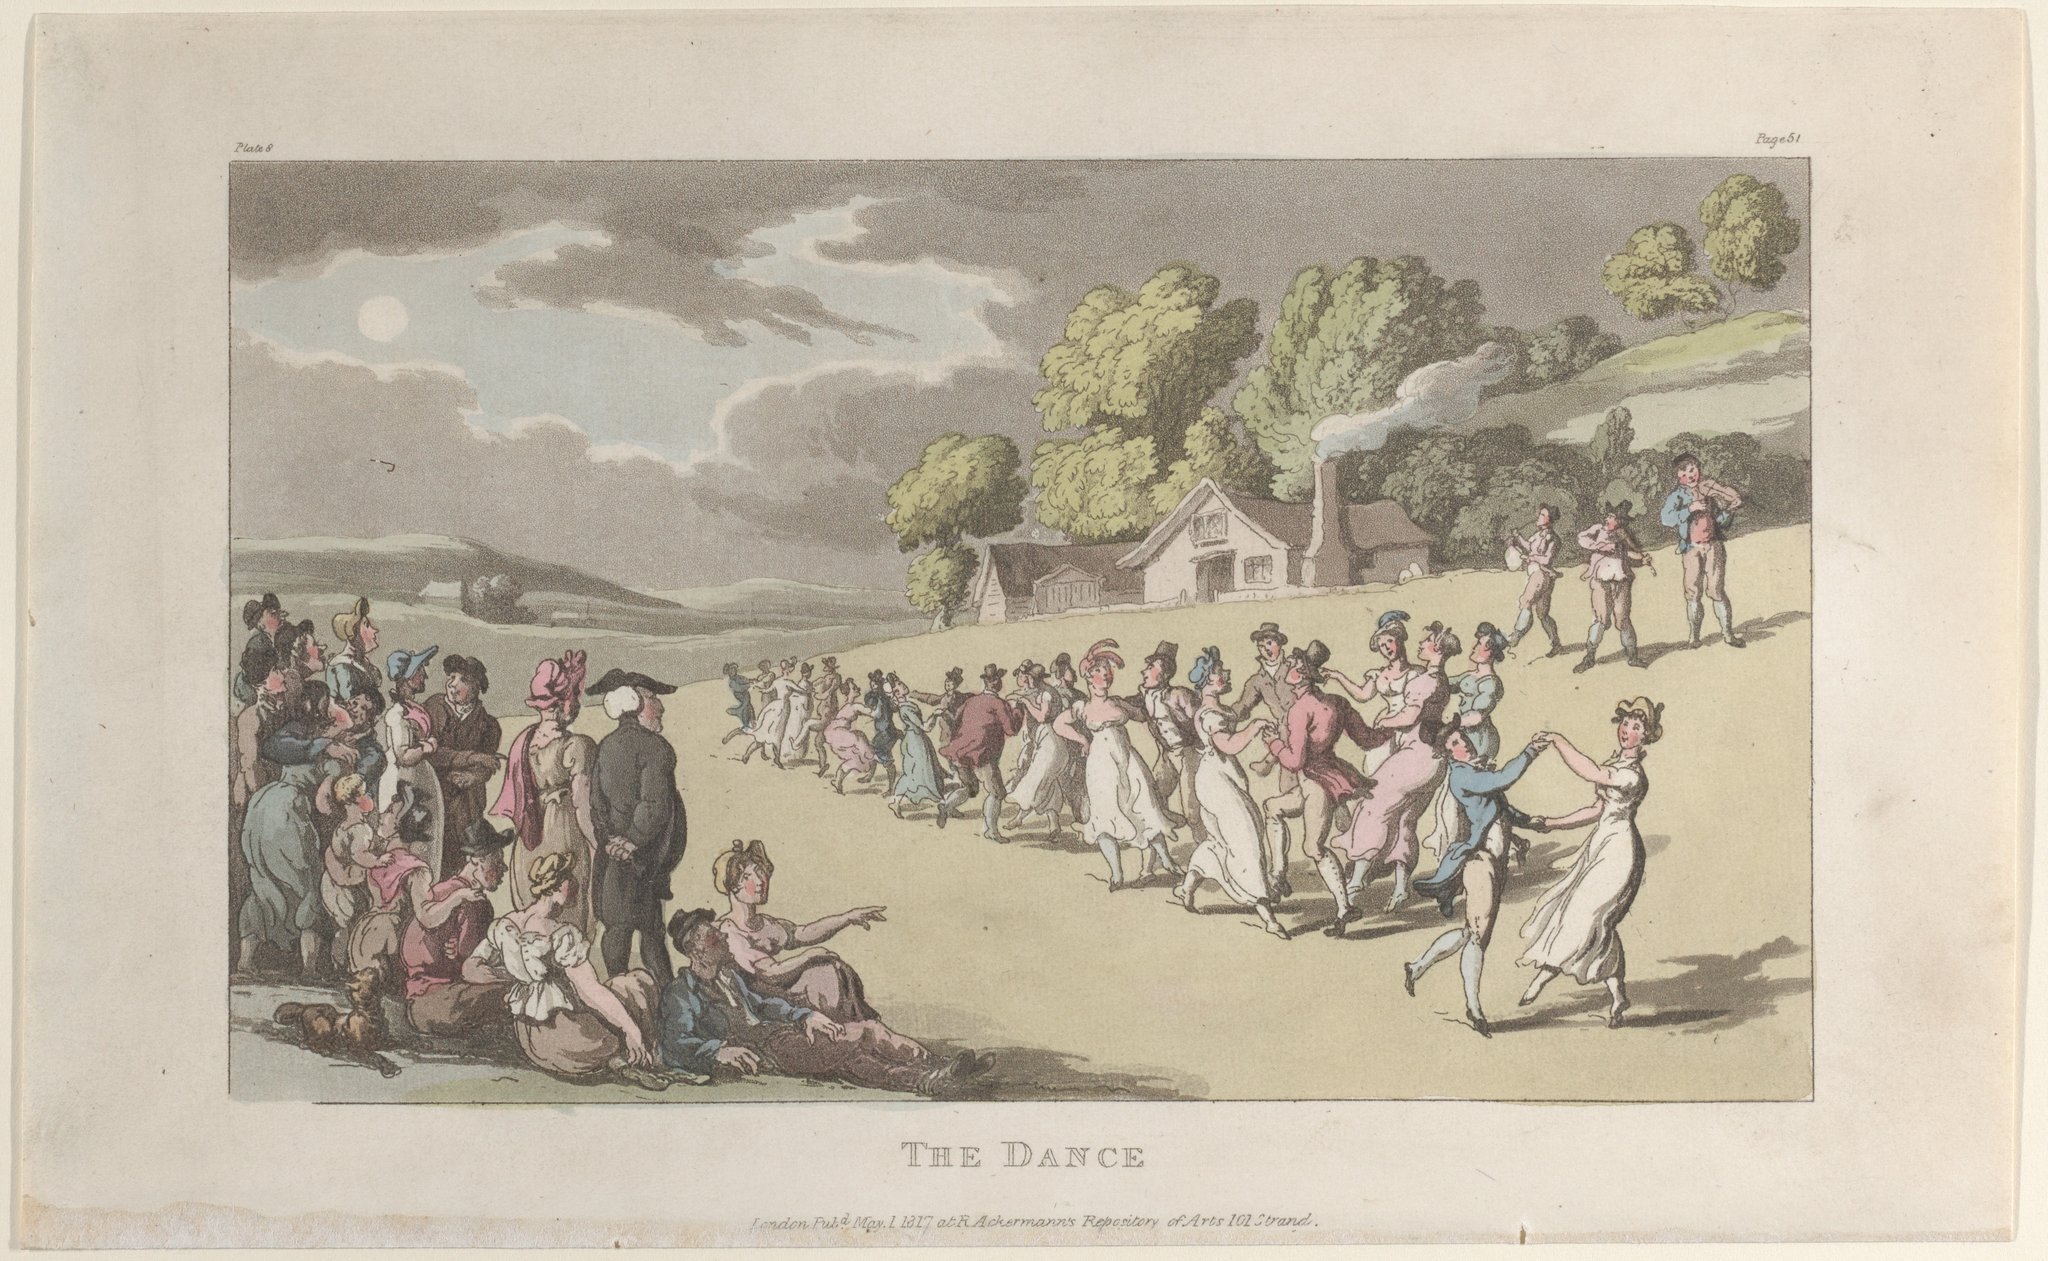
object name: print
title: The Dance, from "The Vicar of Wakefield"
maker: thomas rowlandson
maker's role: artist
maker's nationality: british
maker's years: 1757-1827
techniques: aquatint, etching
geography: london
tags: men,women,dancing